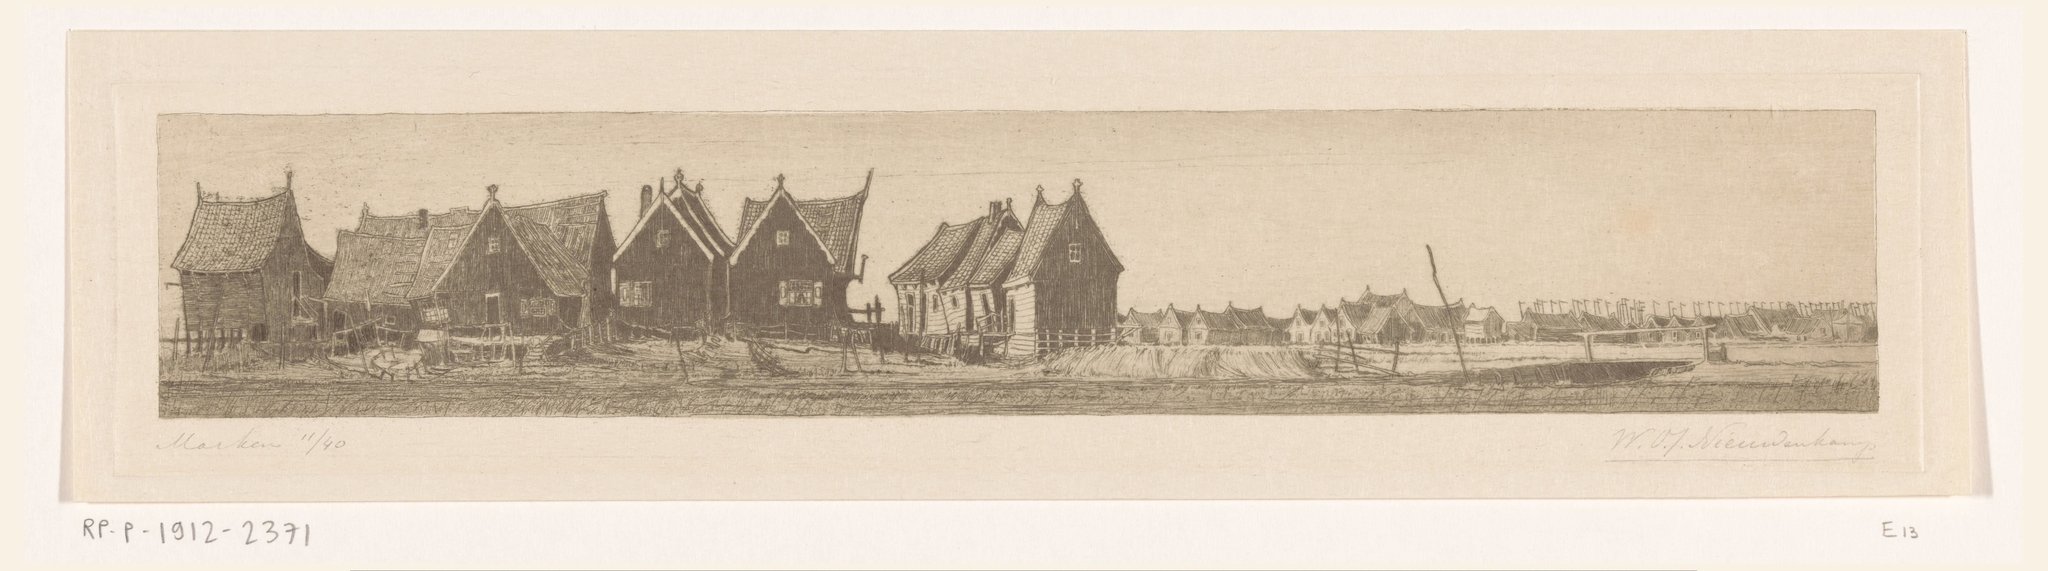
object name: print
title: Op het eiland Marken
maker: wijnand otto jan nieuwenkamp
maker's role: draughtsman, print maker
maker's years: 1874-1950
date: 1896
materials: paper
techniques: etching, intaglio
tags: village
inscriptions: collector's mark: Lugt 2228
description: De Wittewerf op het eiland Marken. Op de achtergrond de Havenbuurt.